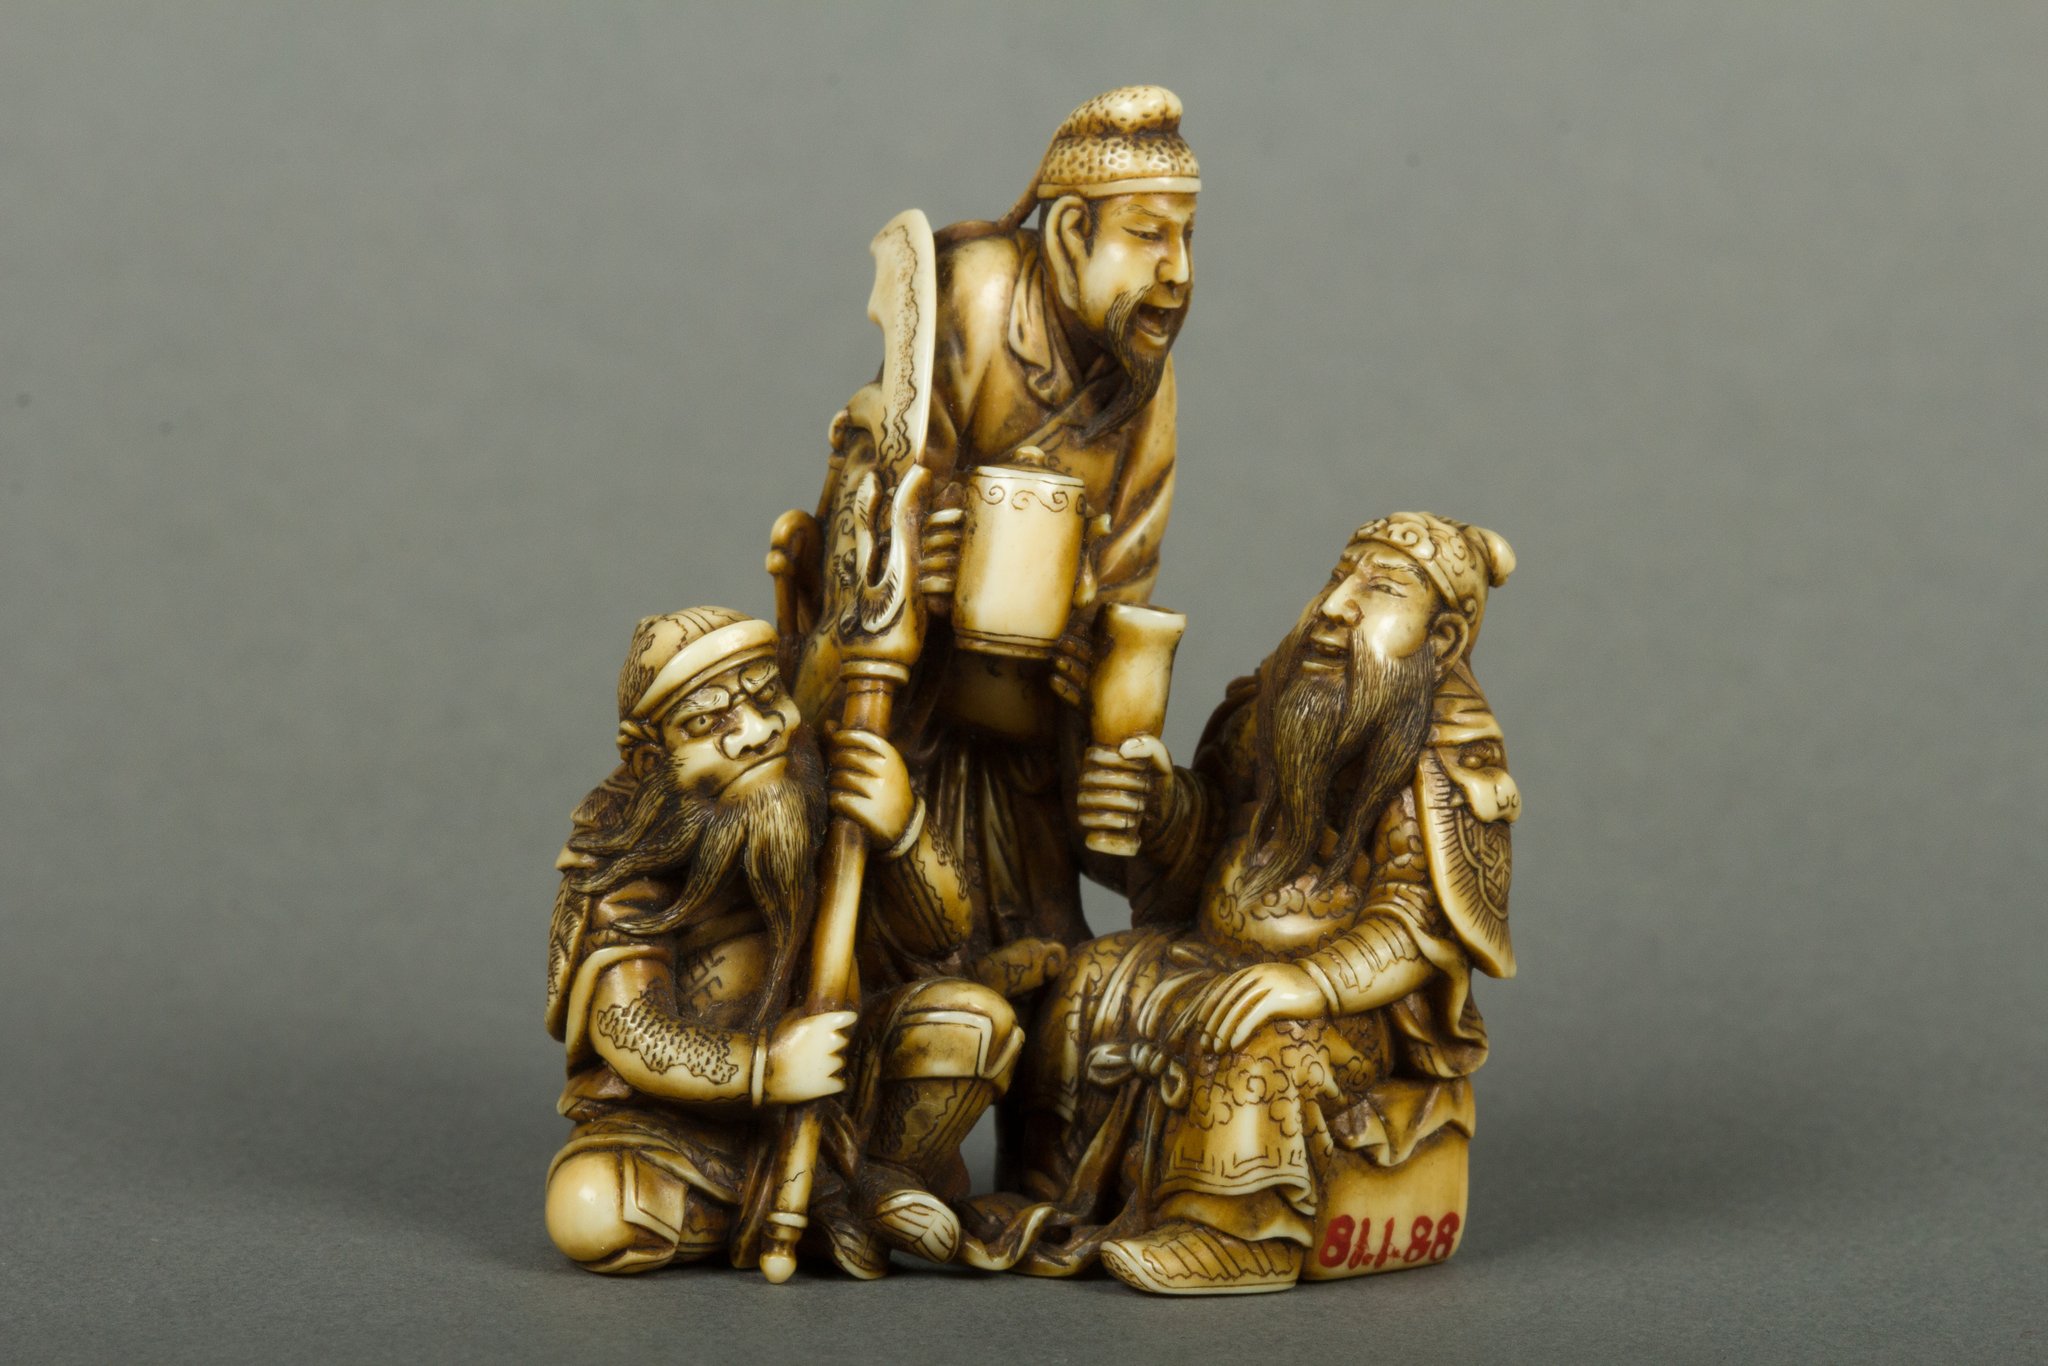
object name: netsuke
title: Group of Figures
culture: japanese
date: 1801-1900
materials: ivory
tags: men,drinking